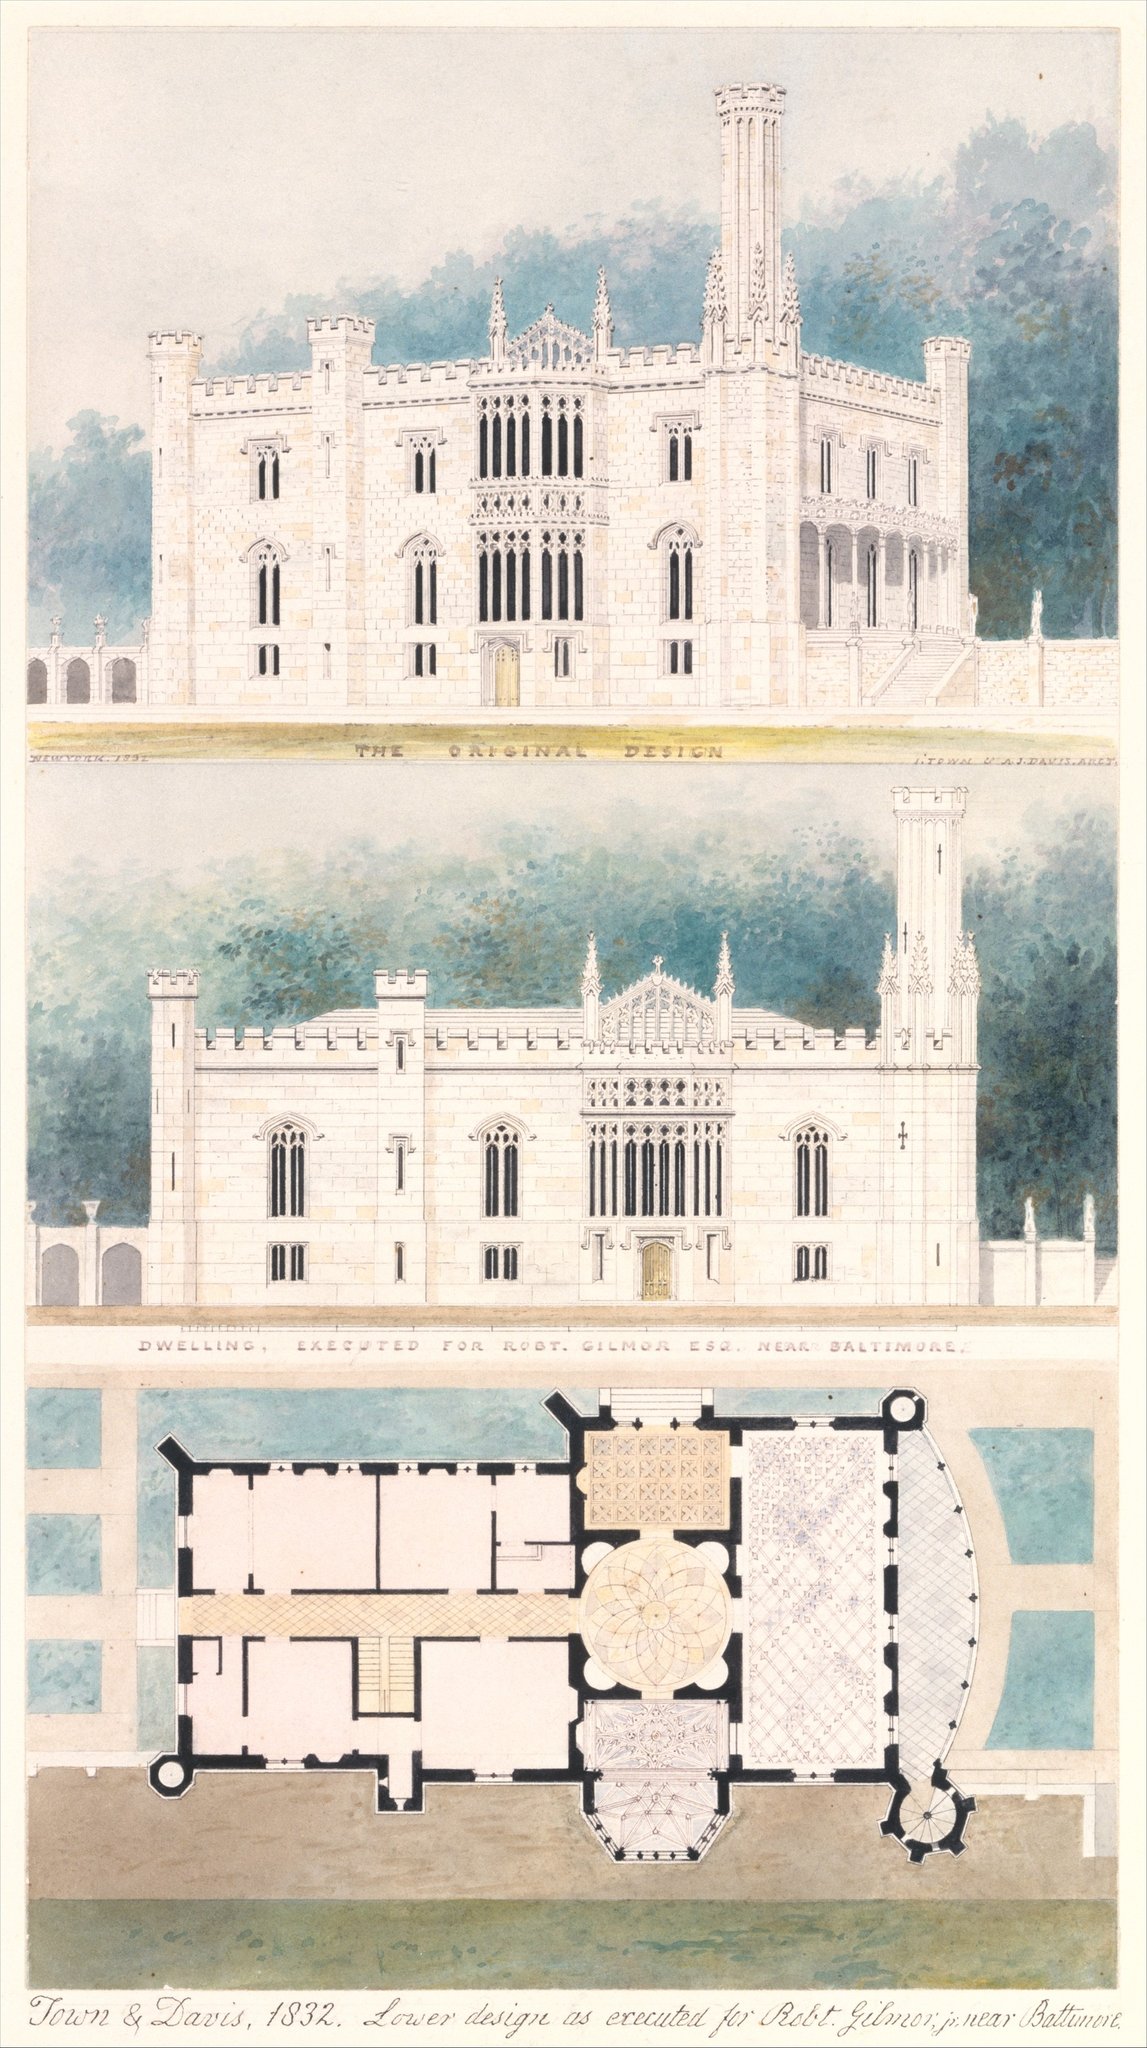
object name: drawing ornament architecture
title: Glen Ellen for Robert Gilmor, Towson, Maryland (perspective, elevation, and plan)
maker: alexander jackson davis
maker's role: artist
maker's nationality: american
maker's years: 1803-1892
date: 1832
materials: graphite, ink, paper, watercolor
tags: architecture,houses